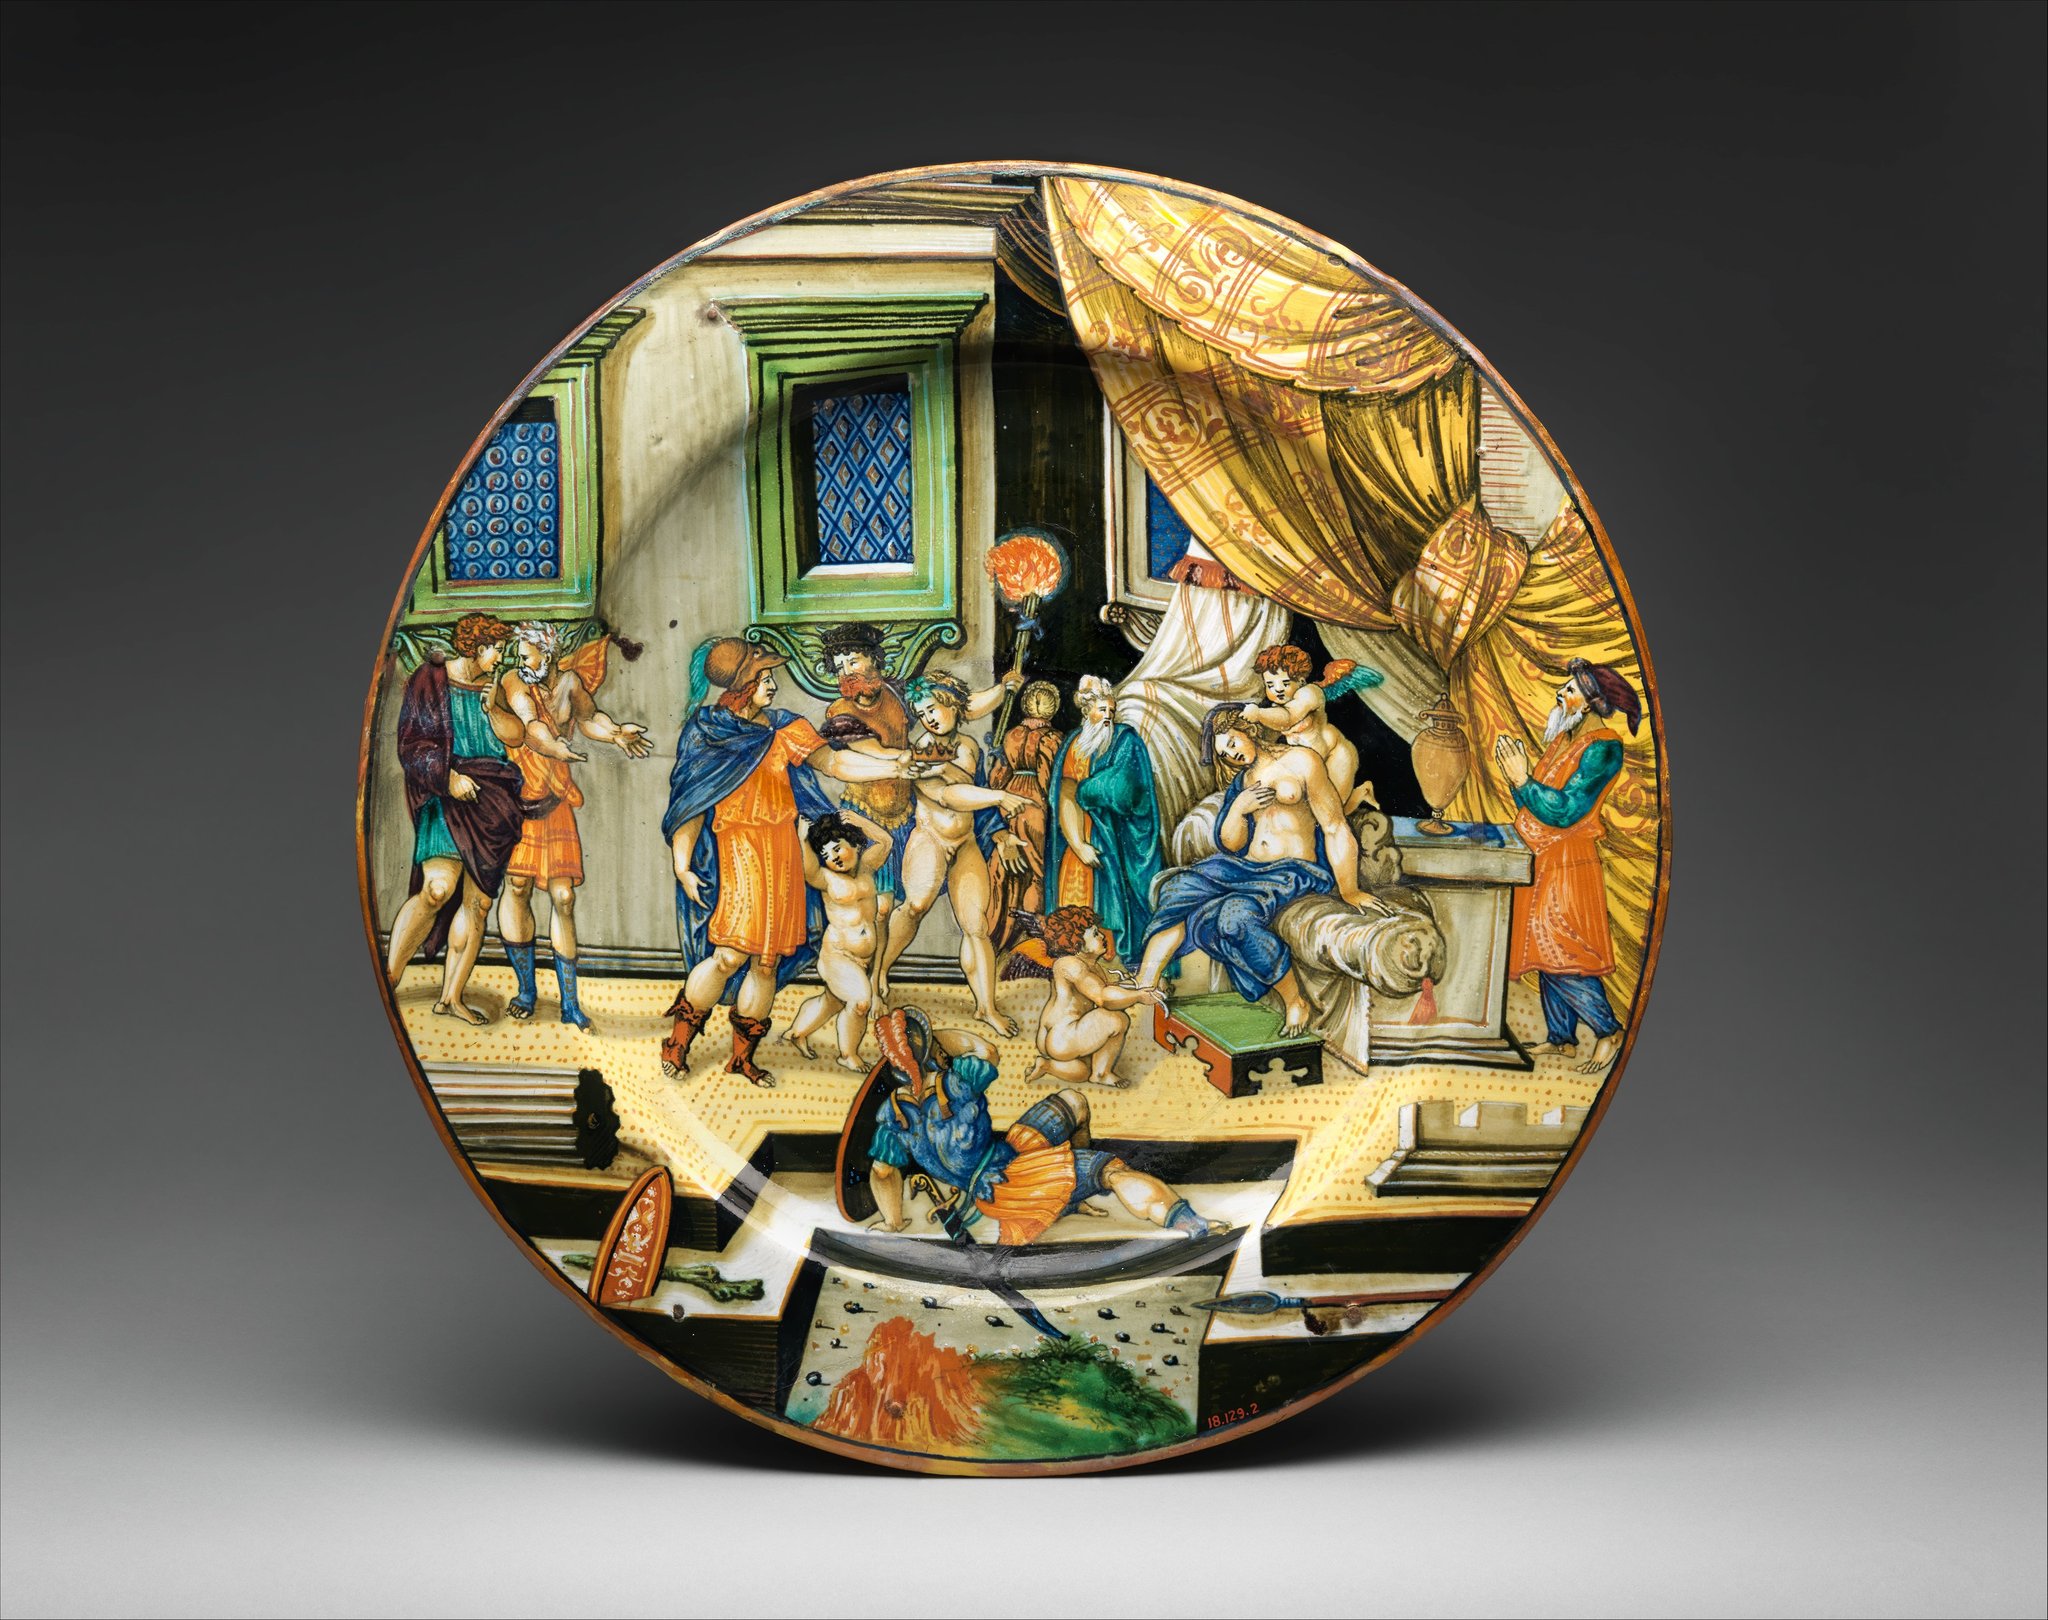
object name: dish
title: Dish with The Story of Semiramis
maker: fra xanto avelli da rovigo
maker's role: artist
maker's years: 1486-1582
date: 1534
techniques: maiolica, glazing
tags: men,women,putti